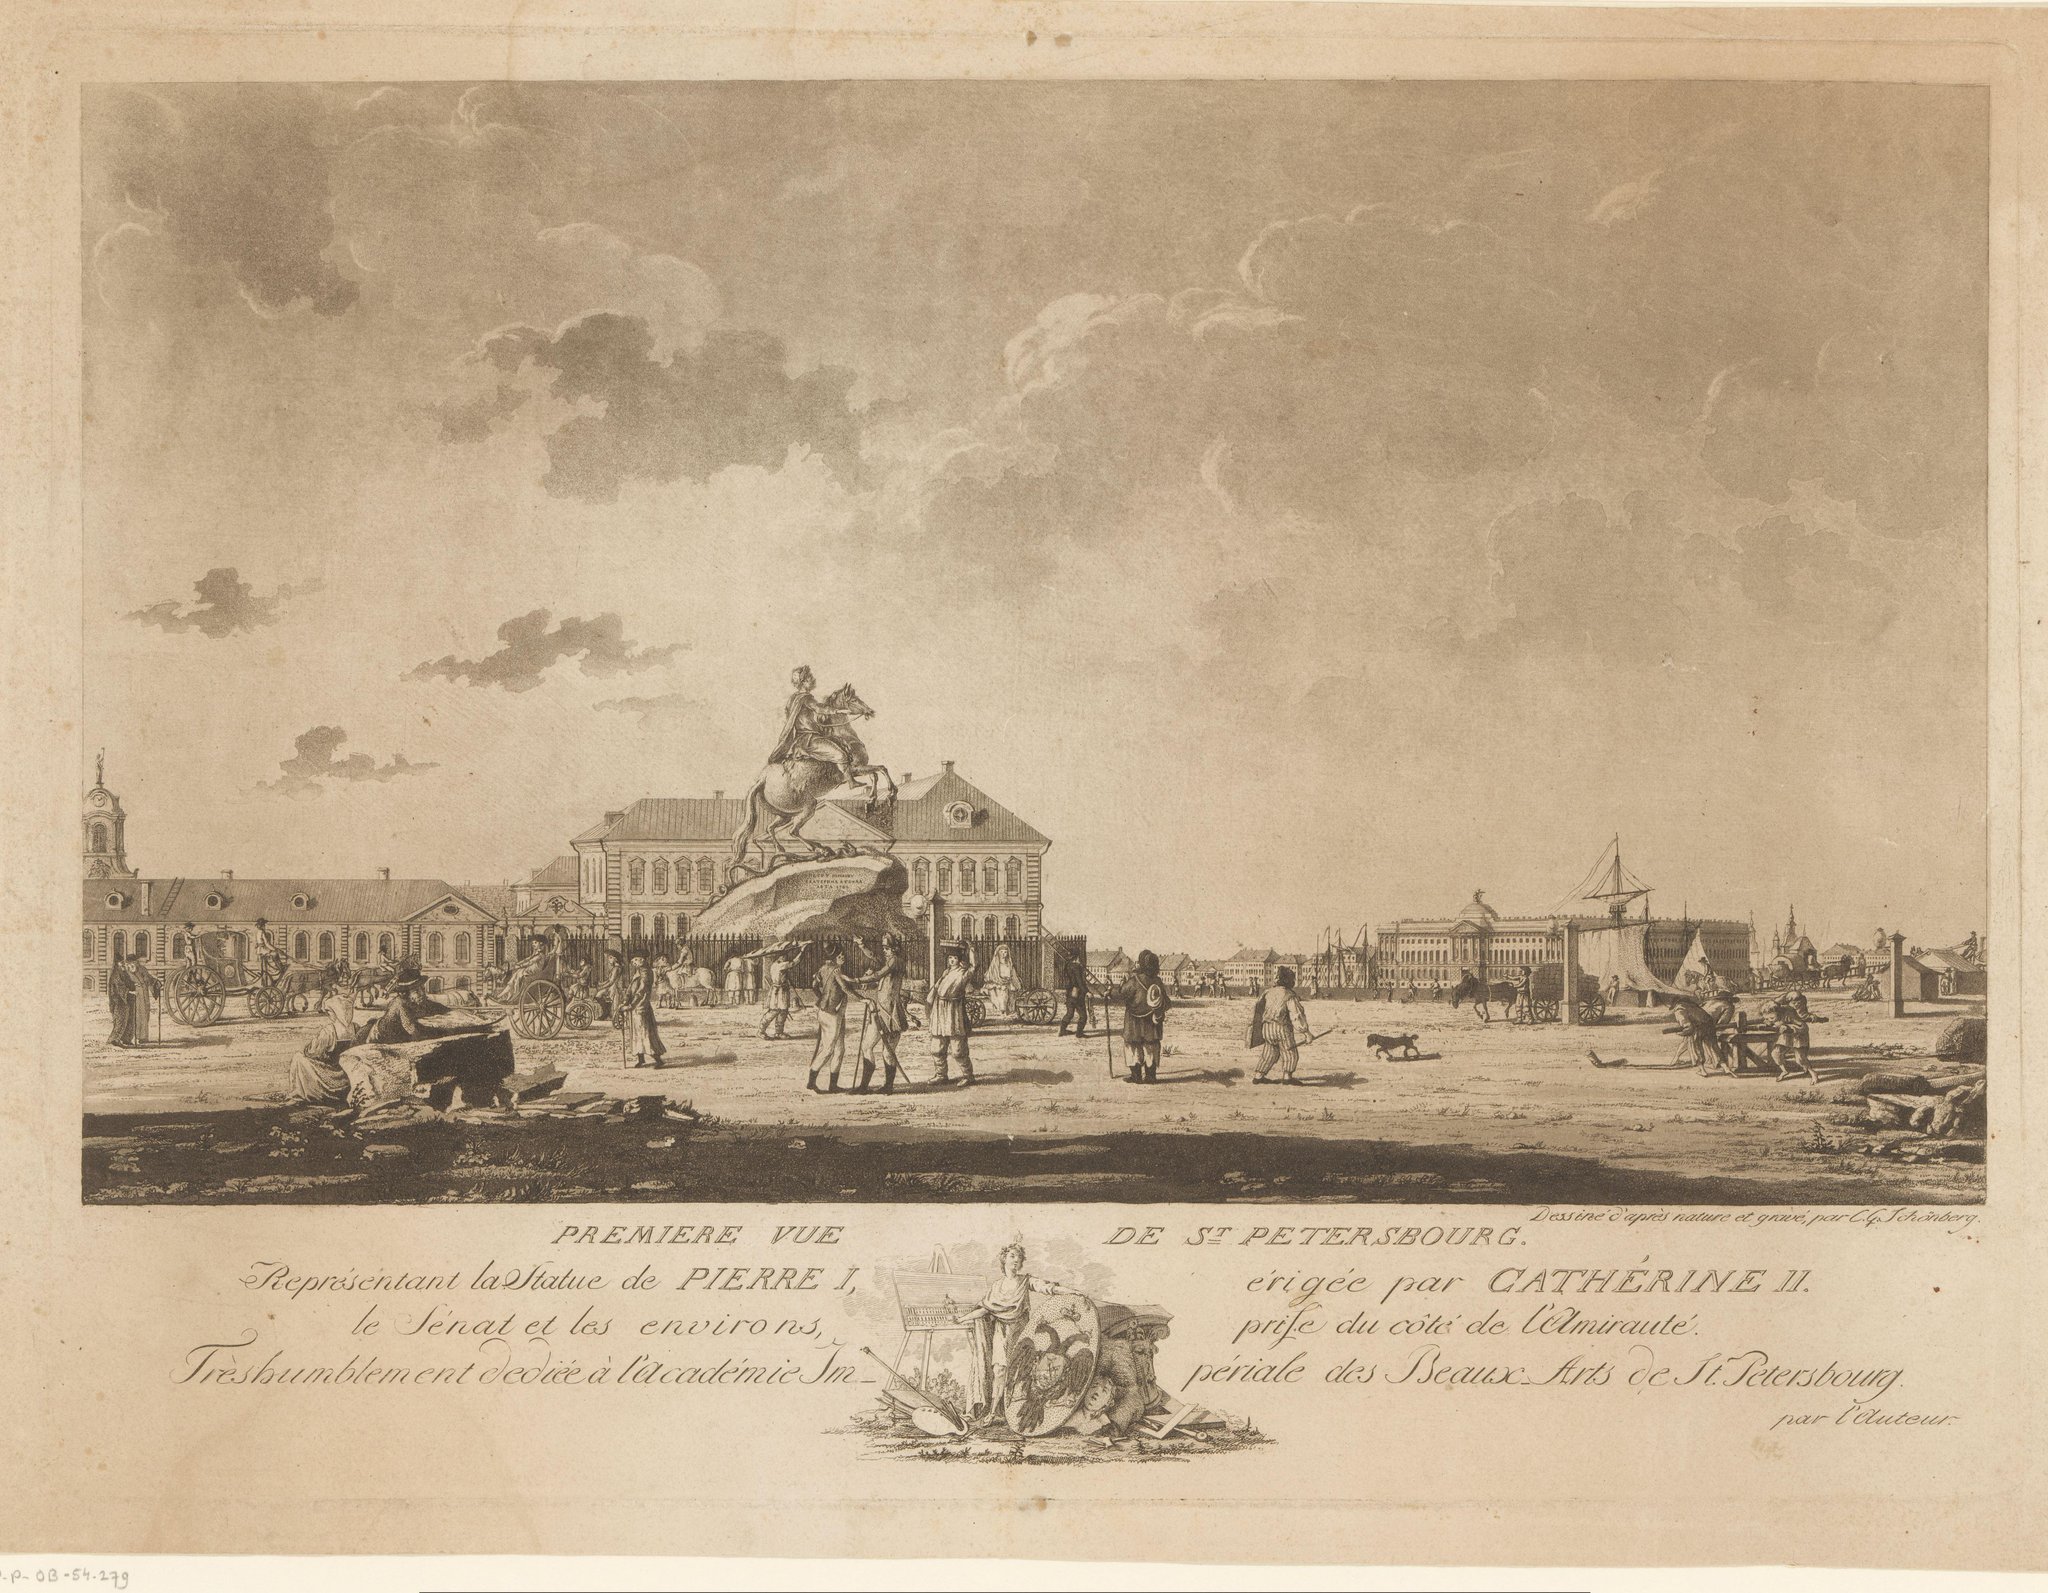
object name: print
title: Plein met ruiterstandbeeld van Peter de Grote in Sint Petersburg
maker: christian gotthelf schönberg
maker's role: print maker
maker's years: 1760-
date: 1794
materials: paper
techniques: aquatint, etching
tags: peter i de grote (tsaar van rusland), monument, statue, armorial bearing, heraldry